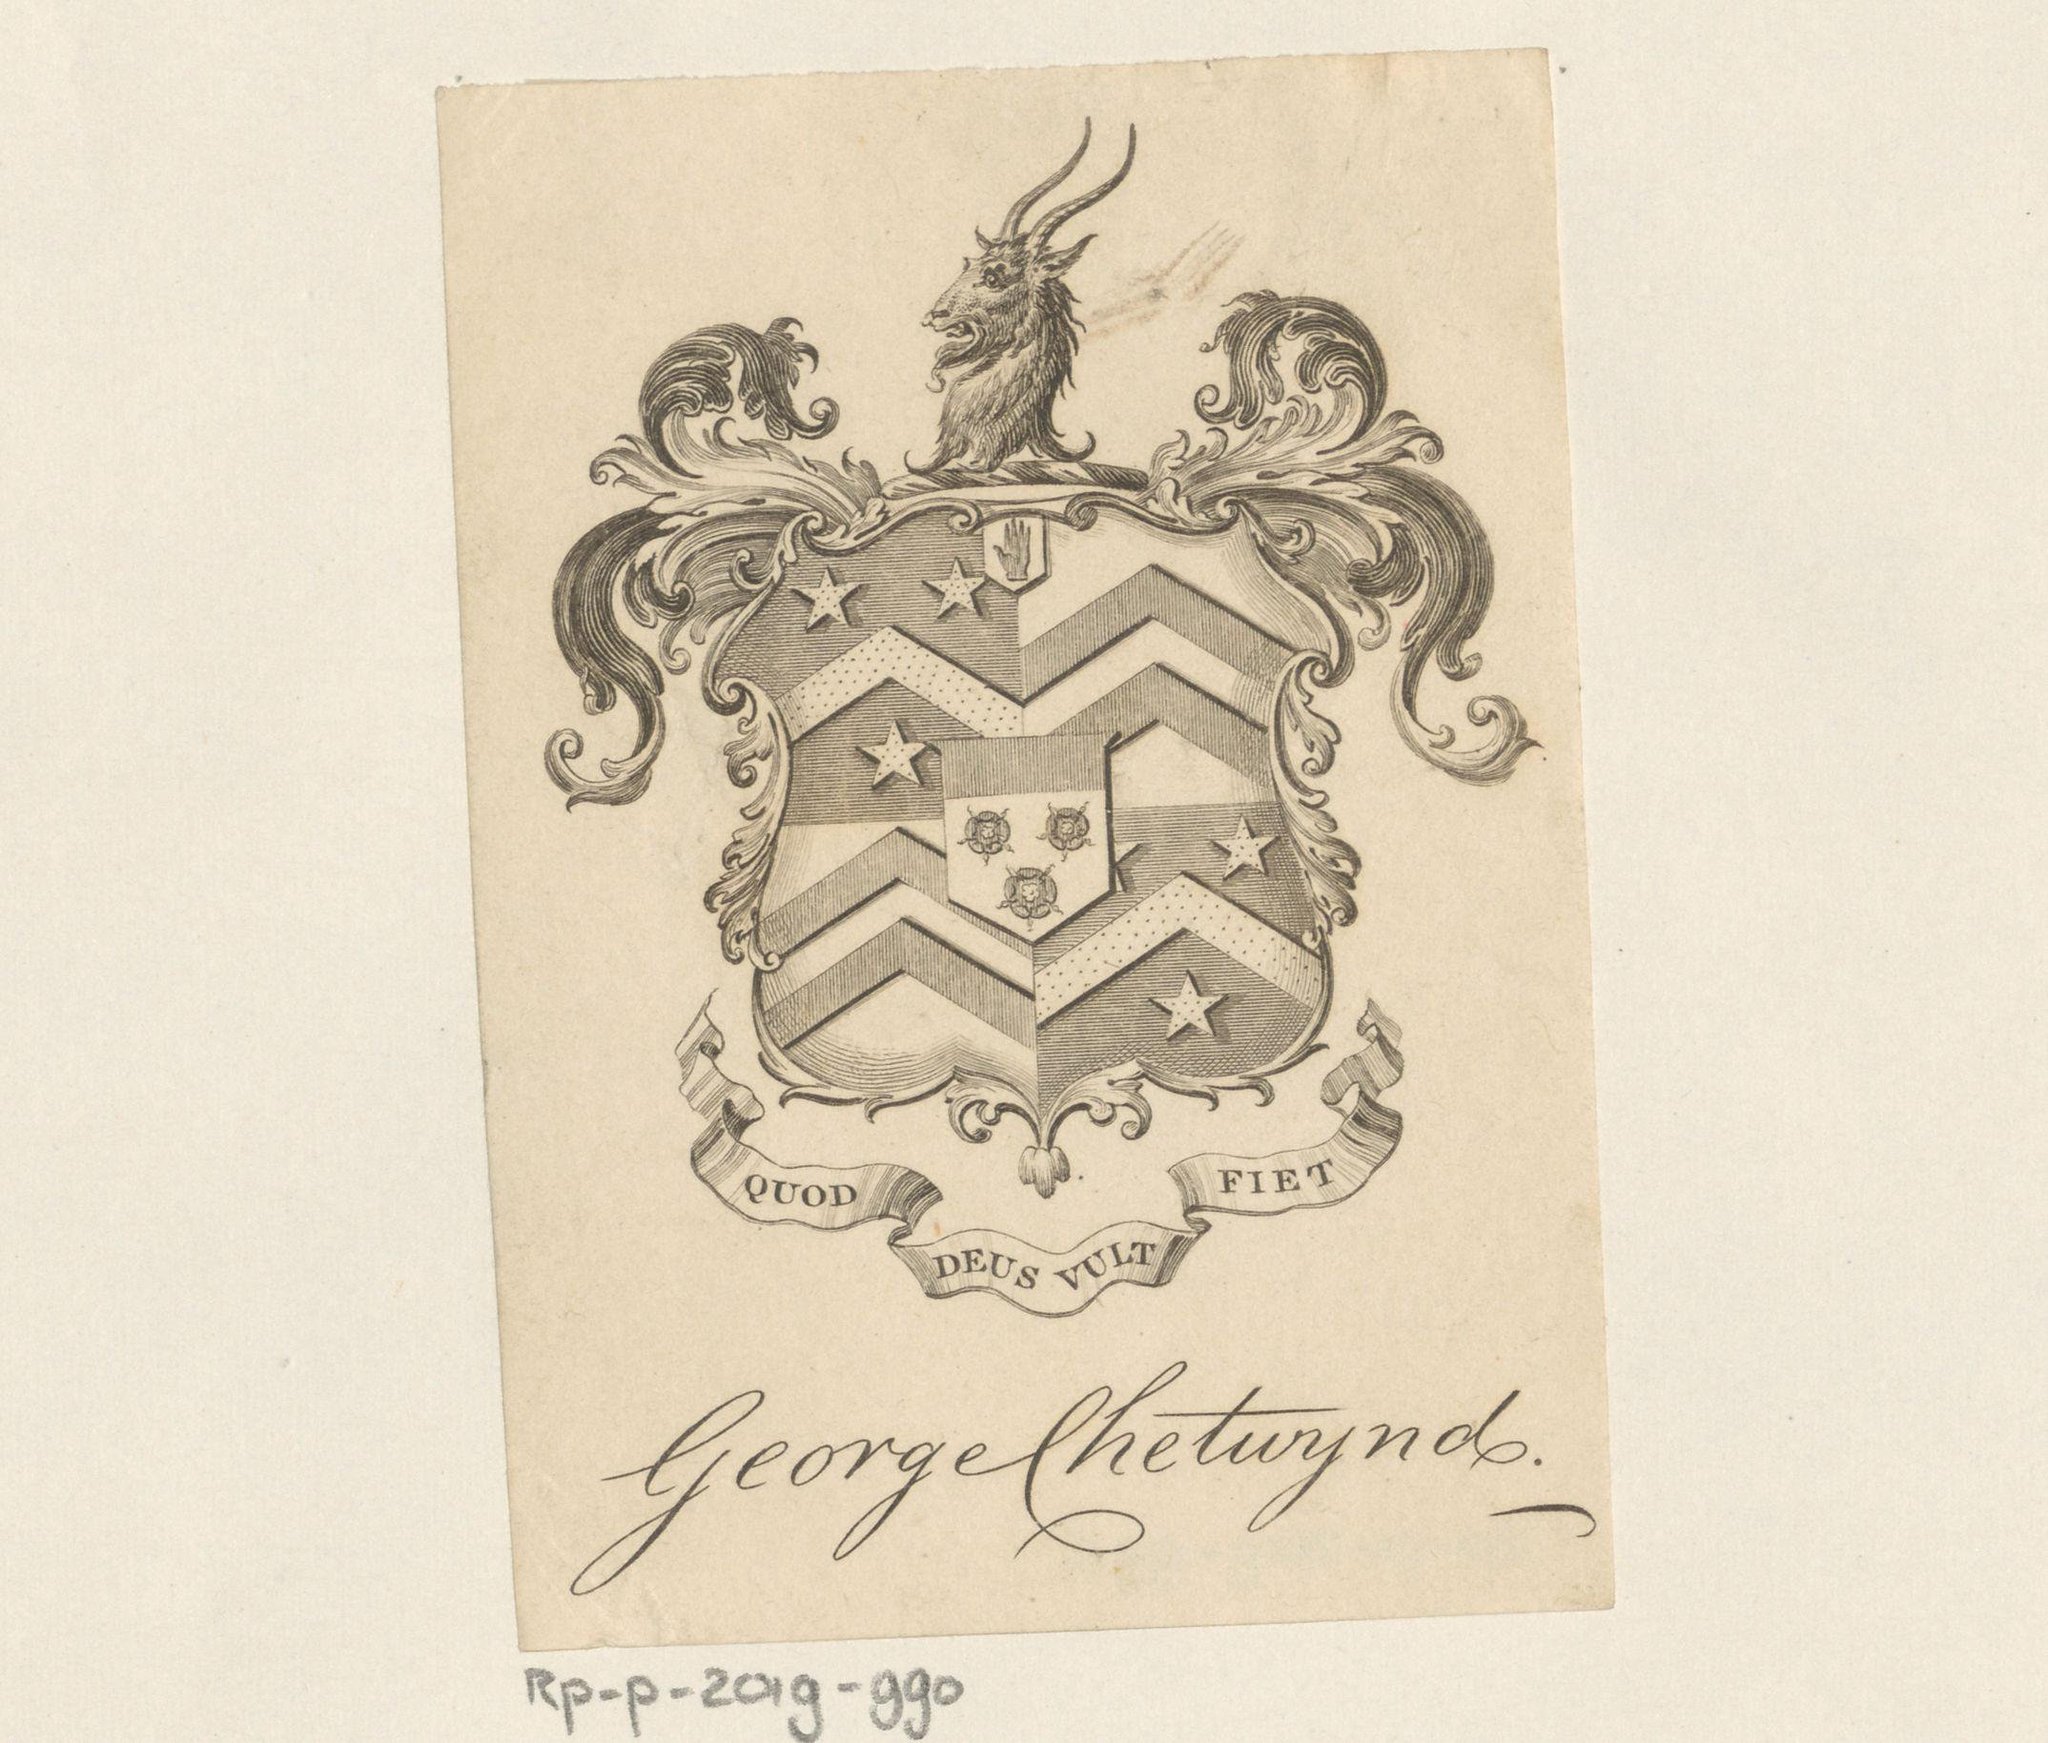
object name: bookplate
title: Ex libris van George Chetwynd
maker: Anonymous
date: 1800-1899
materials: paper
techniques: engraving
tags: armorial bearing, heraldry